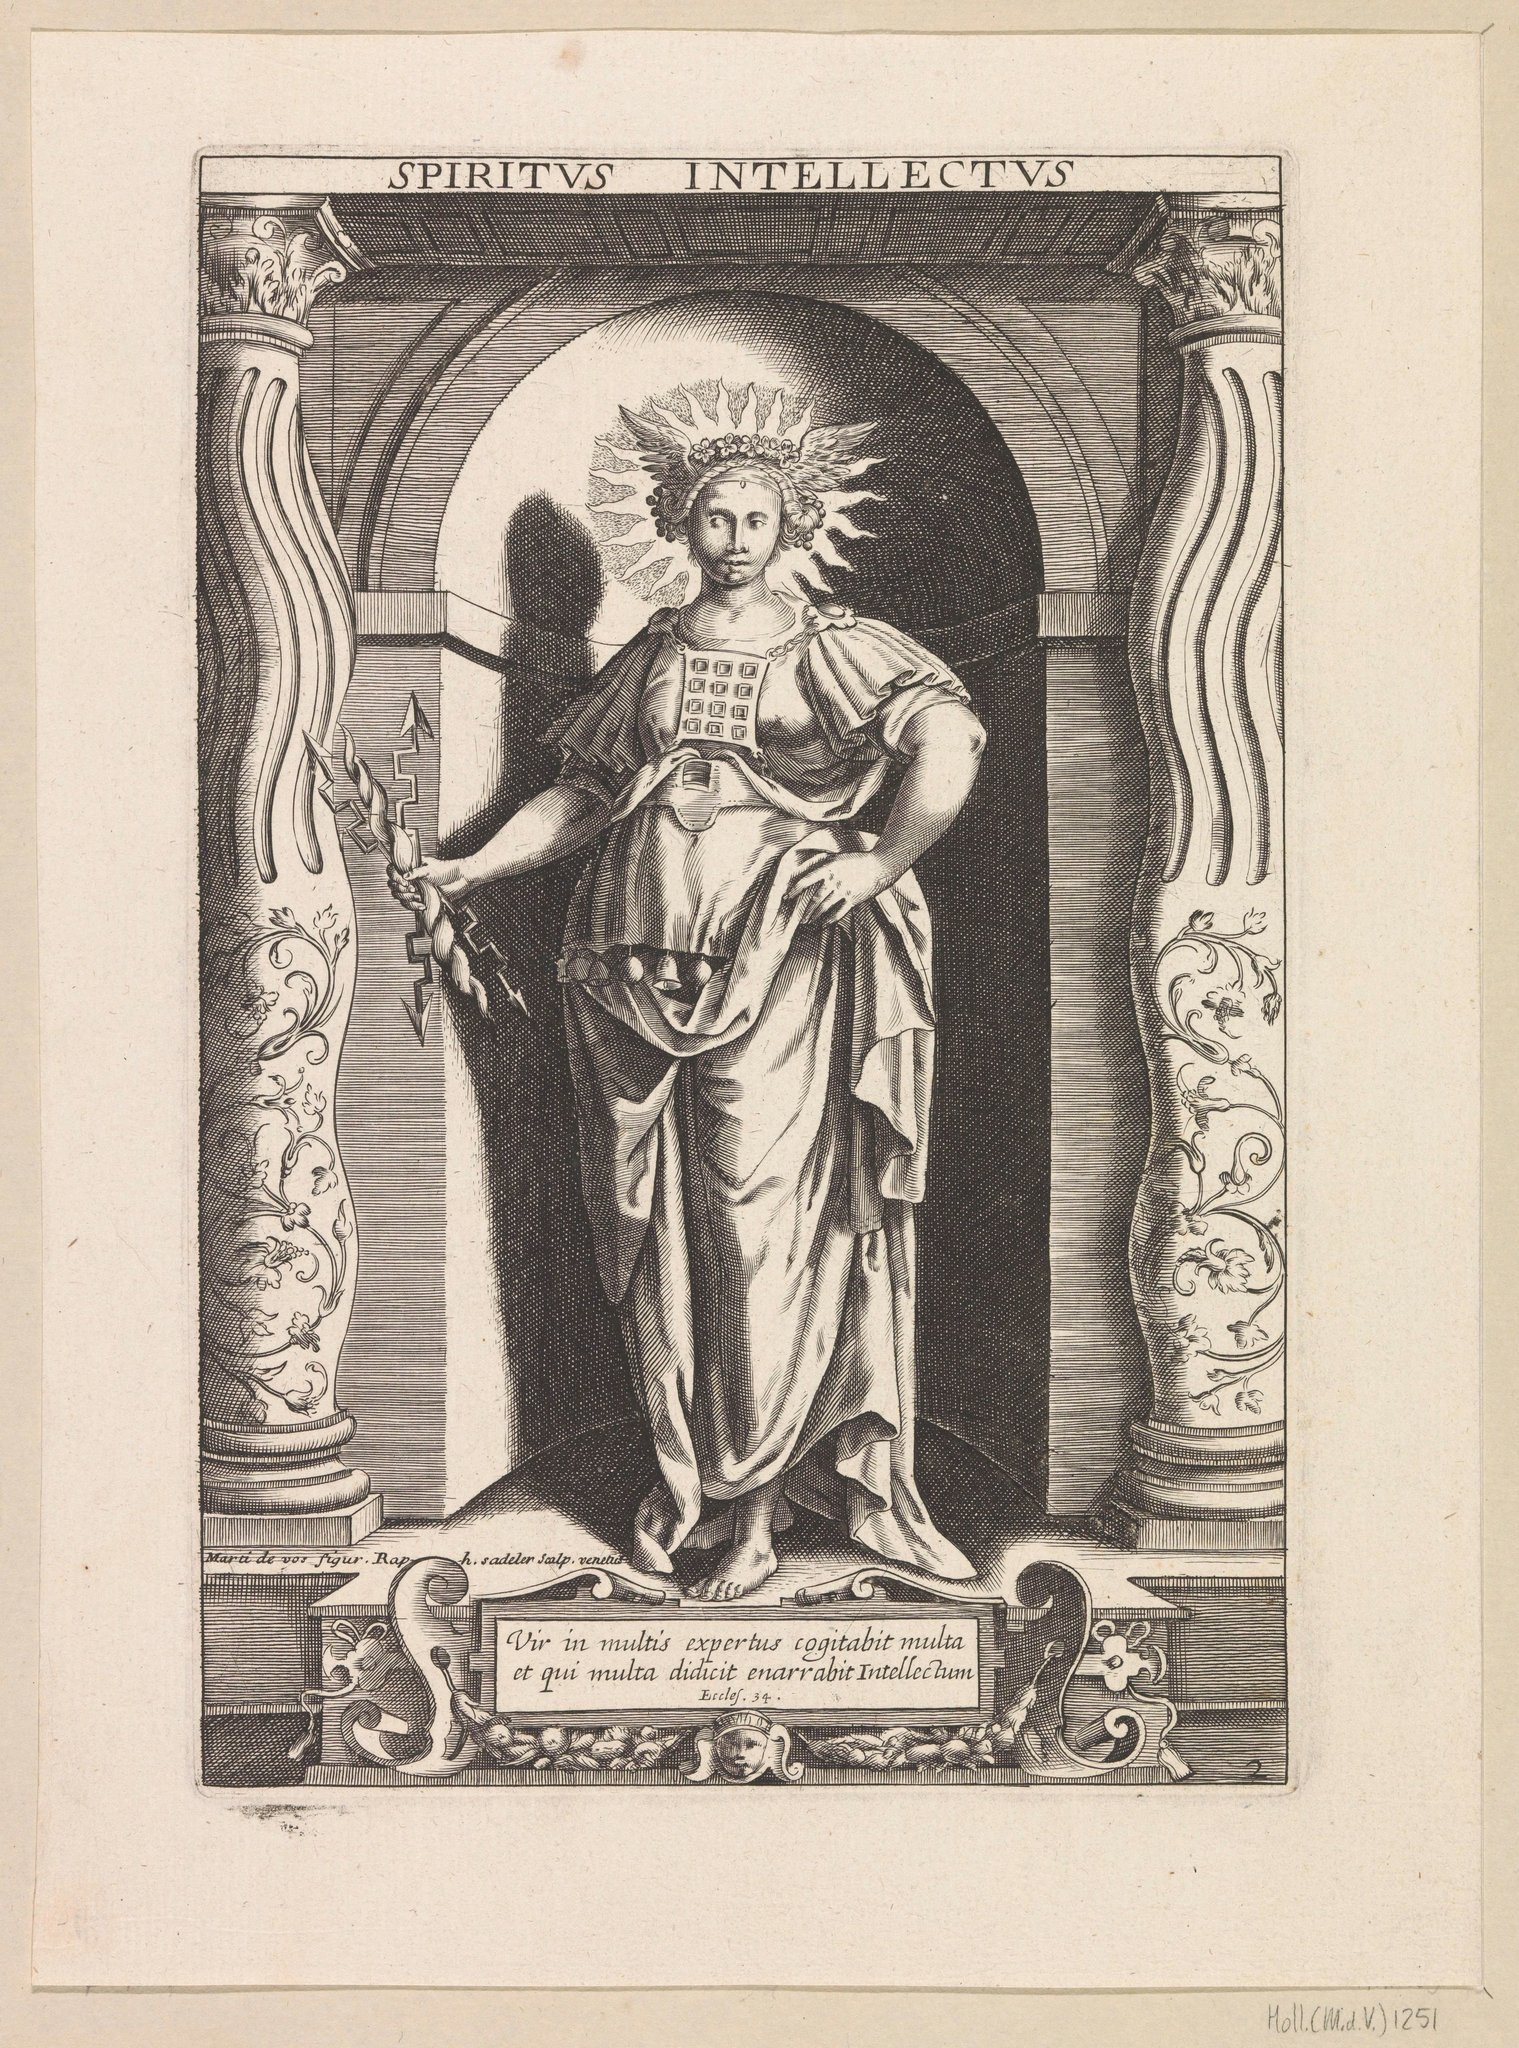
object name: print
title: Zeven gaven van de Heilige Geest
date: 1598-1604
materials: paper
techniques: engraving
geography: venice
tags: 'intellectus', 'intelligentia', understanding ~ one of the seven gifts of the holy ghost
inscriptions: collector's mark: Lugt 240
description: In een nis de vrouwelijke personificatie van de gave van verstand, een van de zeven gaven van de Heilige Geest. Ze draagt een gevleugelde kroon en in haar rechterhand heeft ze een bliksemschicht. Rond haar hoofd een stralende zon.